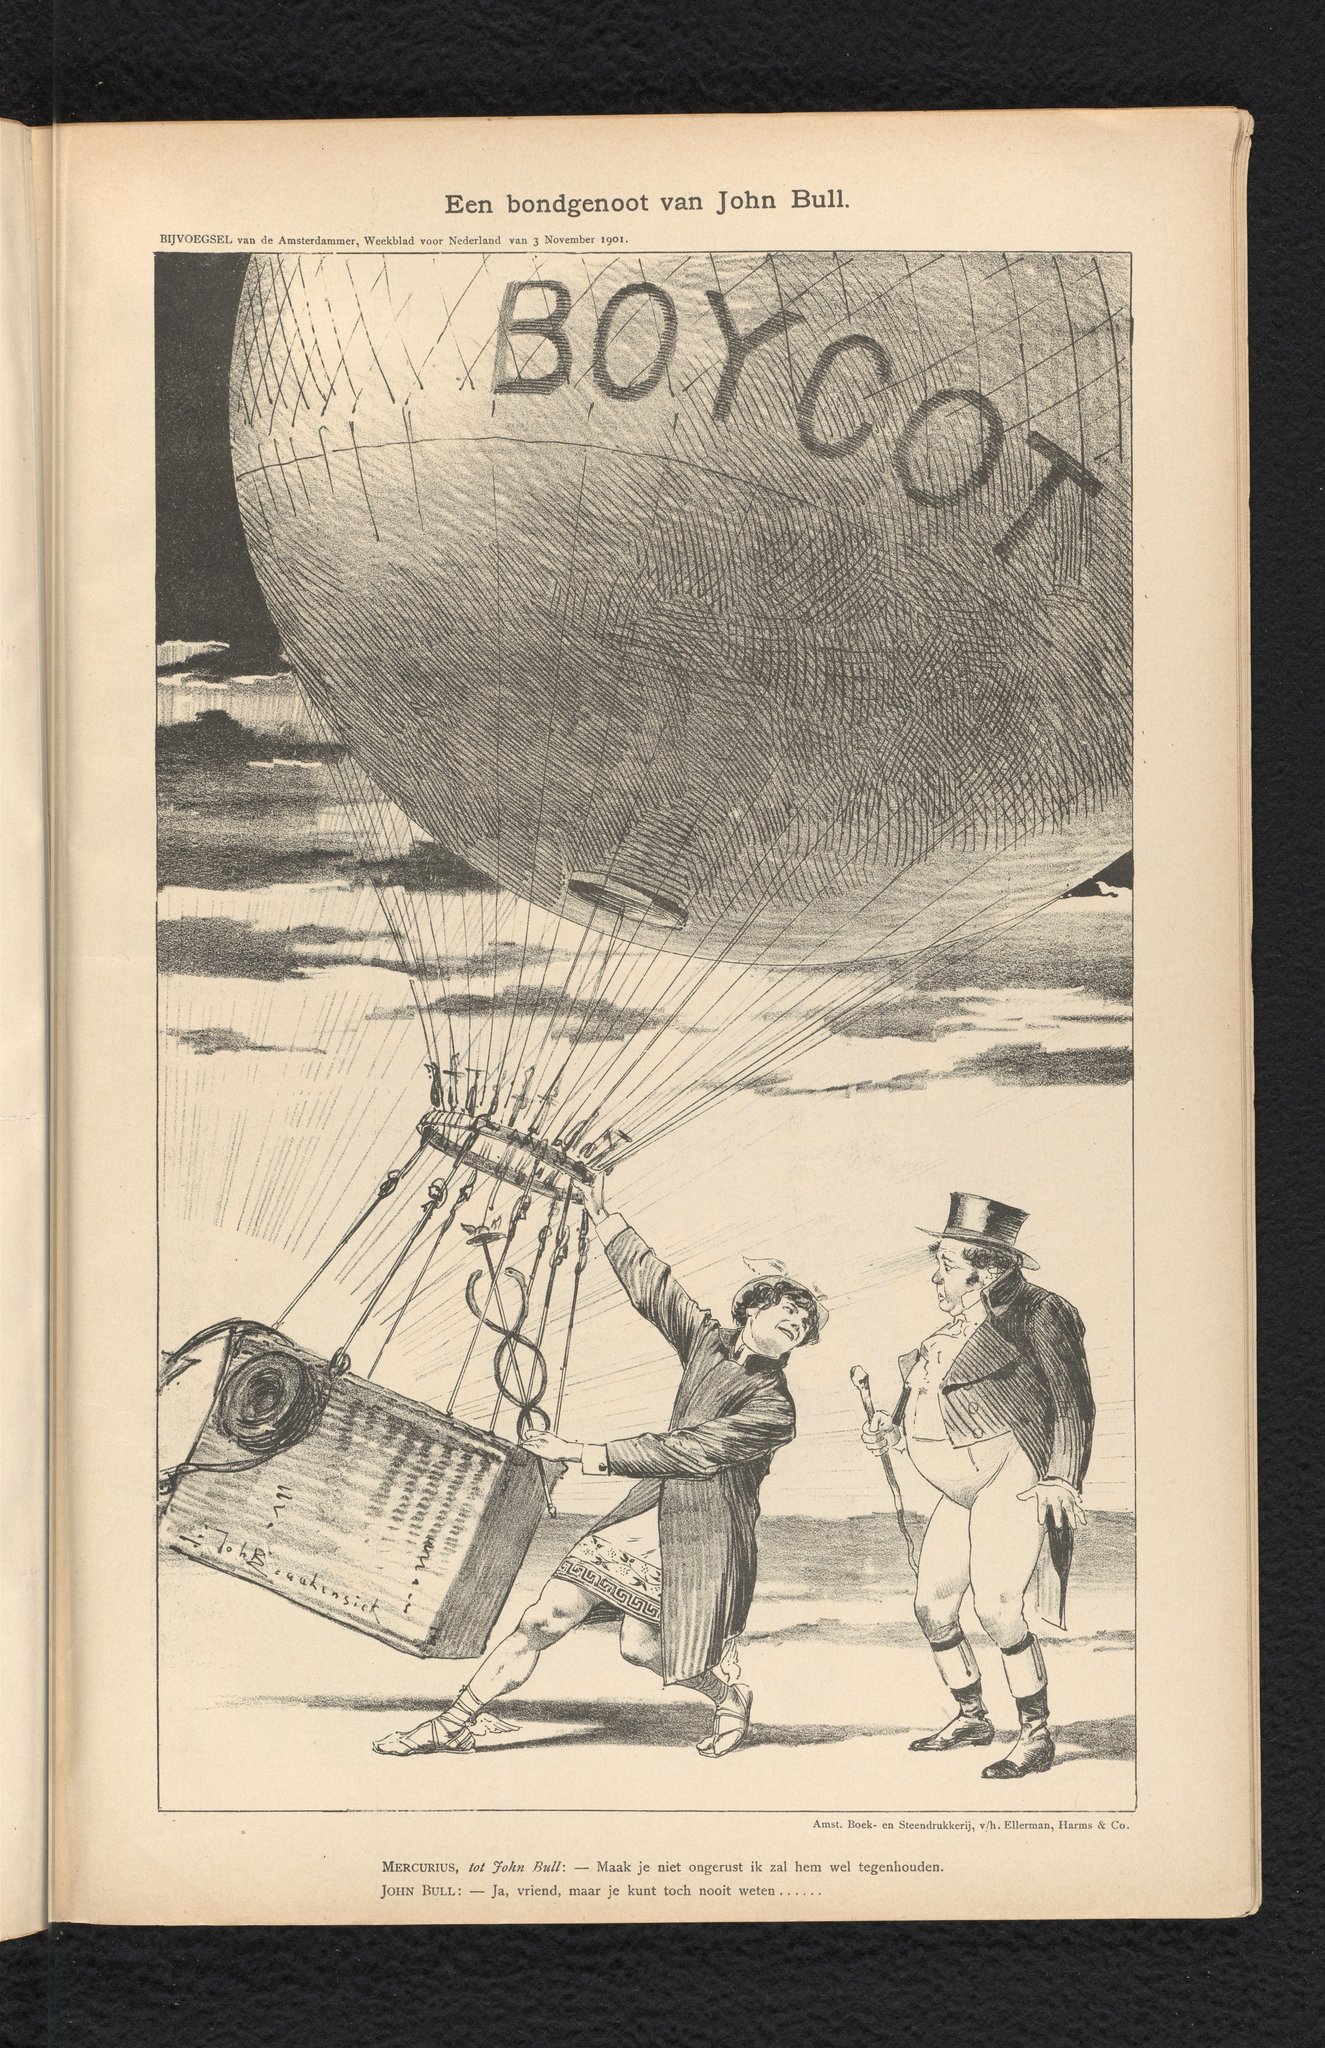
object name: cartoon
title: Een bondgenoot van John Bull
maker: johan braakensiek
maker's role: draughtsman, print maker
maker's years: 1858-1940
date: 1901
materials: paper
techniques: lithograph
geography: netherlands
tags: personifications of countries, nations, states, districts, etc., boycott, balloon (aviation), specific aspects, allegorical aspects of mercury; mercury as patron, political caricatures and satires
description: Mercurius (Handel) houdt de luchtballon Boycot aan de grond. John Bull (Engeland) is toch ongerust.